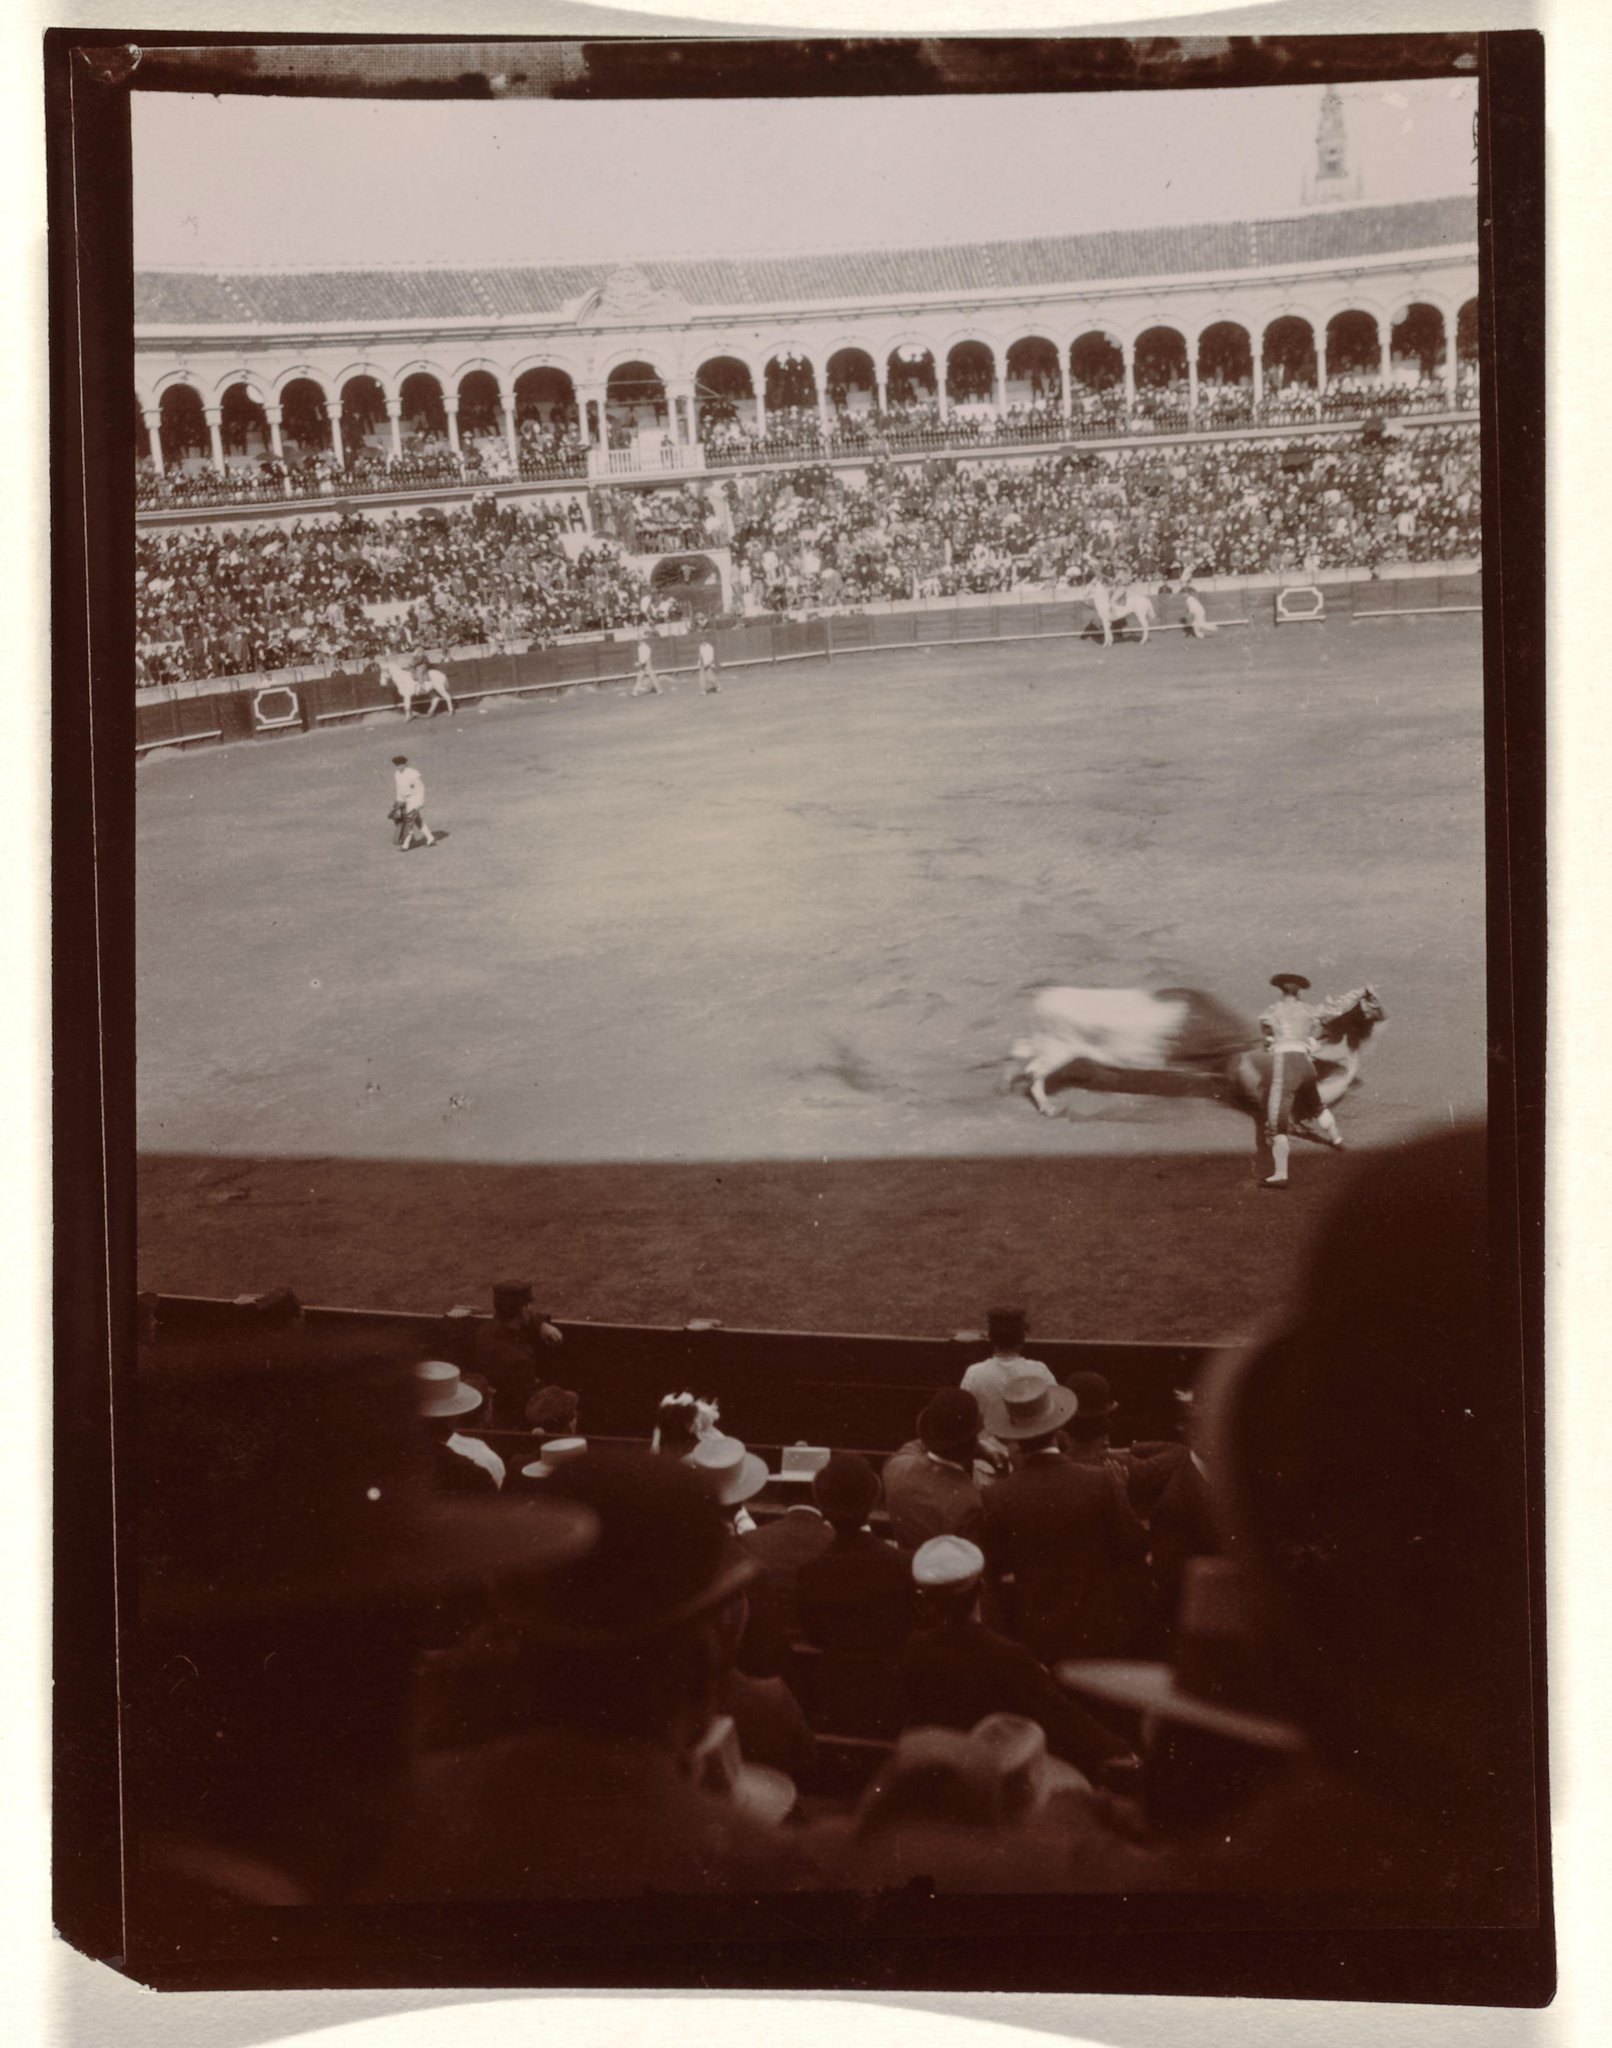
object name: photograph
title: At the Bull Fight, Spain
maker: Anonymous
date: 1905-1922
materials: photographic support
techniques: gelatin silver print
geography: spain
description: Arena voor stierengevechten in Valencia of Barcelona.